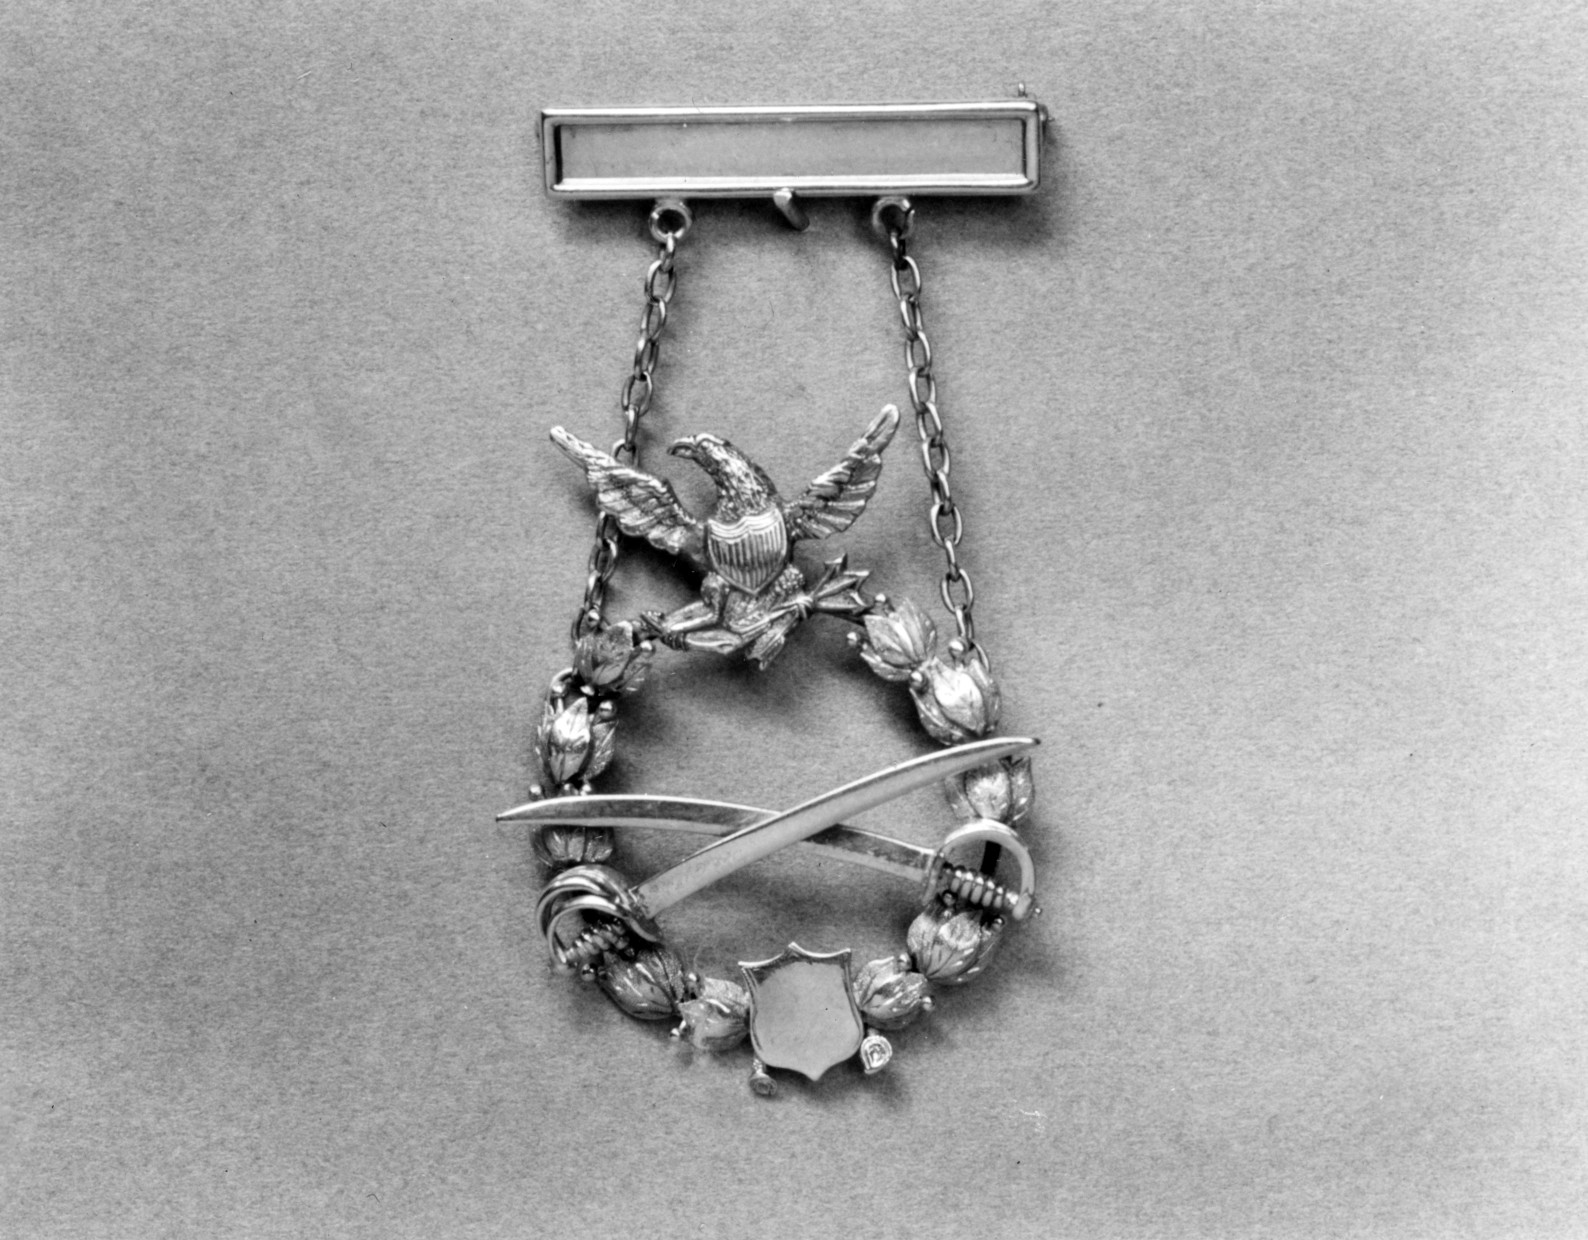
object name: brooch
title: Pin with United States National Coat of Arms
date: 1870-1900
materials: gold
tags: eagles,coat of arms